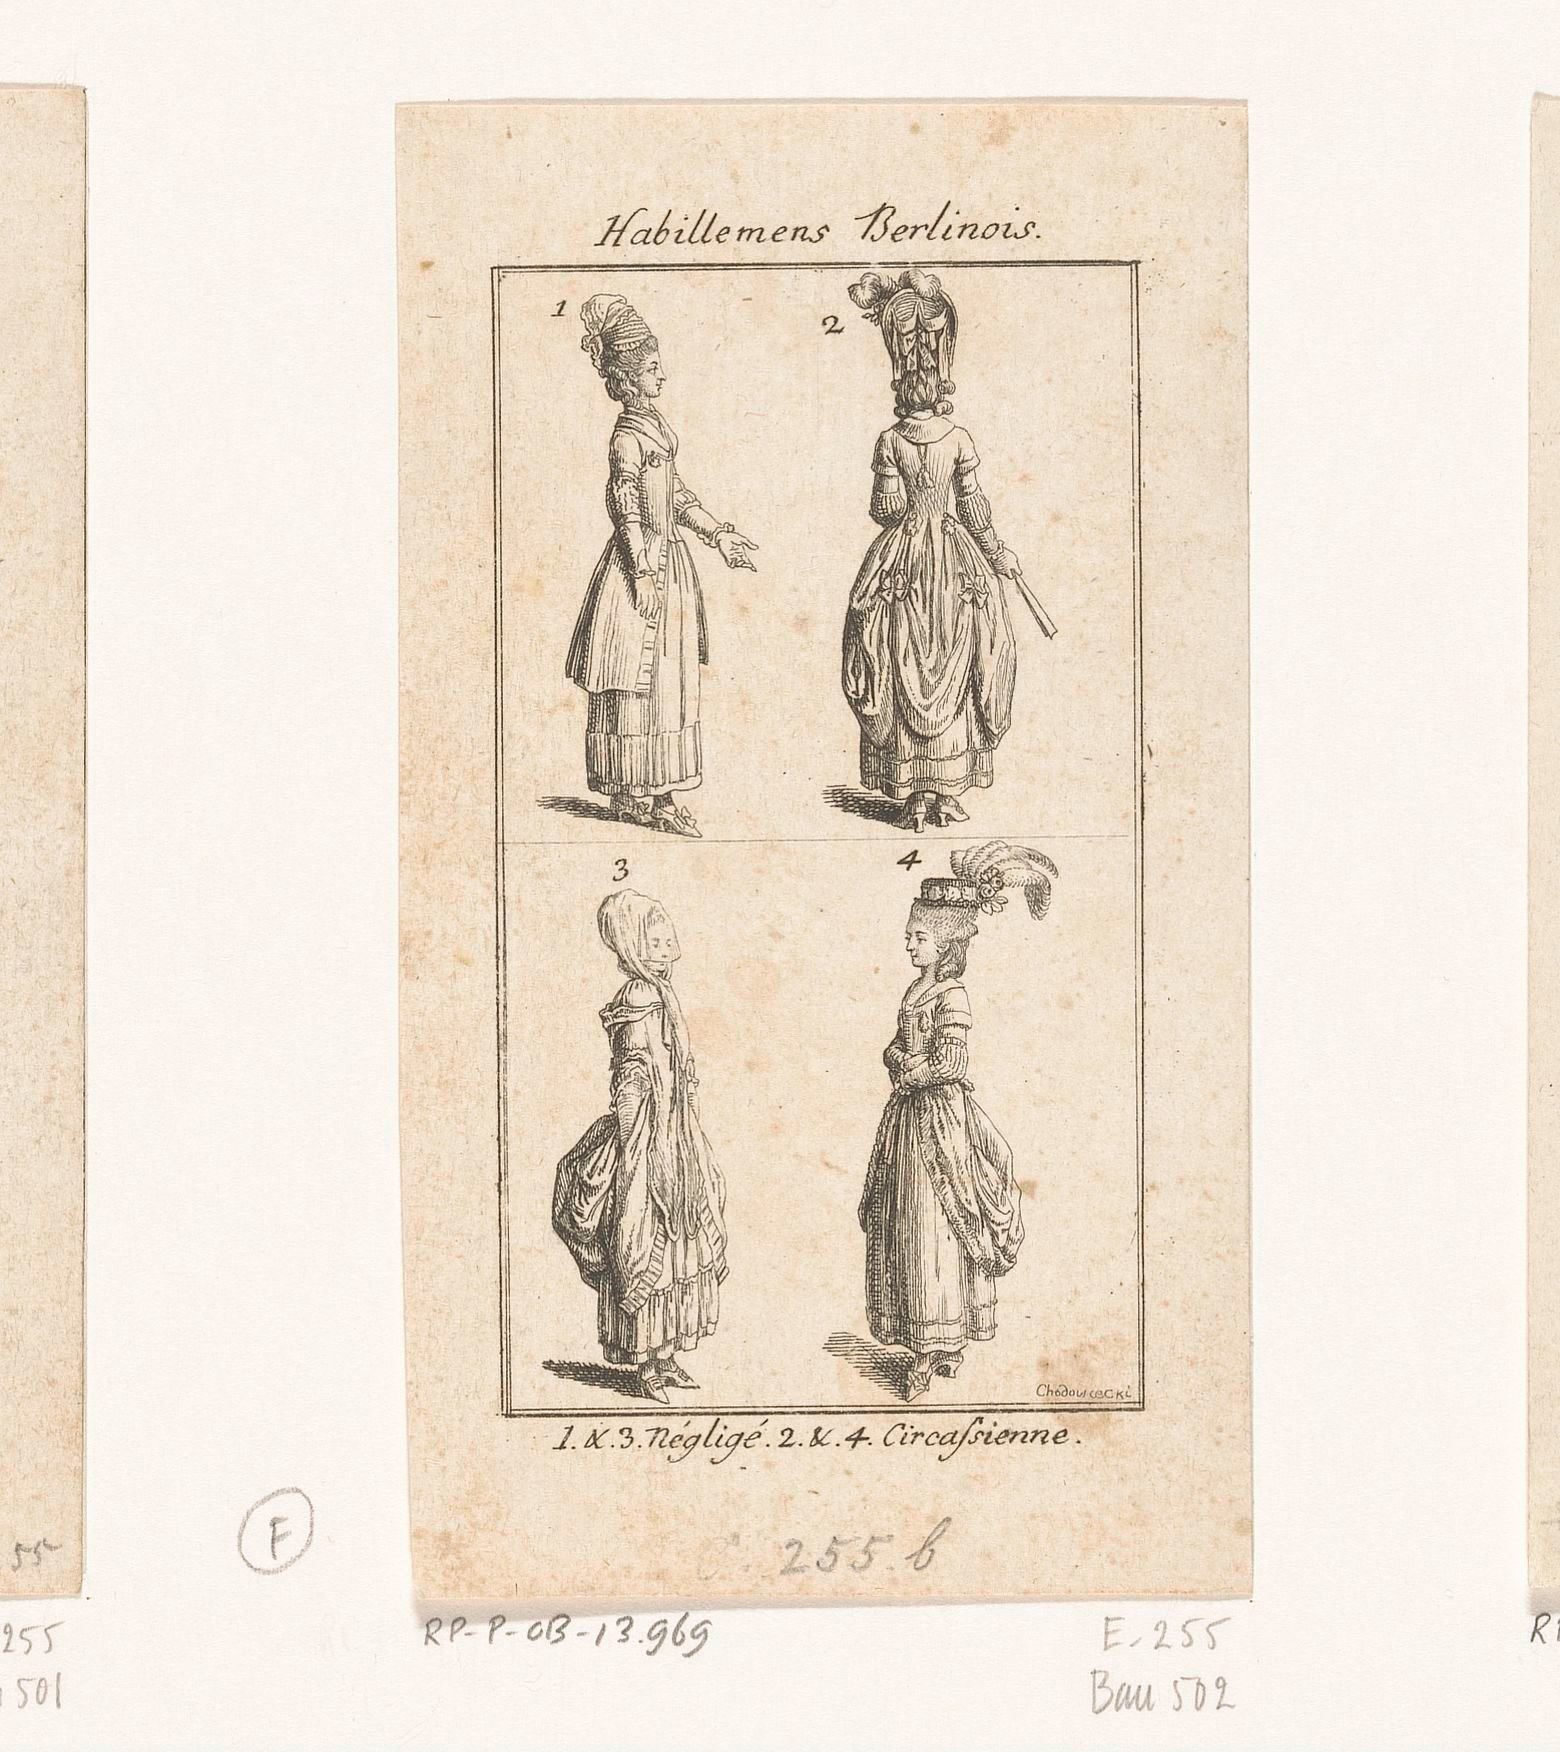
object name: print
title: Vier dameskostuums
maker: daniel nikolaus chodowiecki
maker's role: draughtsman, print maker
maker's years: 1726-1801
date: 1778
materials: paper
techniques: etching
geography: berlin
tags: styles of hairdress - aa - ~ women, dress, gown (+ women's clothes)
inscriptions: collector's mark: Lugt 2228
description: Deze prent maakt deel uit van een serie van vijf voorstellingen met mode en haardrecht. Deze voorstellingen werden samen op een plaat geëtst. Deze prent is ook gebruikt in: Königl. Grossbr. u. Churf. Braunschw. Lüneb. Genealogischer Kalender auf das Jahr 1779. Lauenburg, J.G. Berenberg.